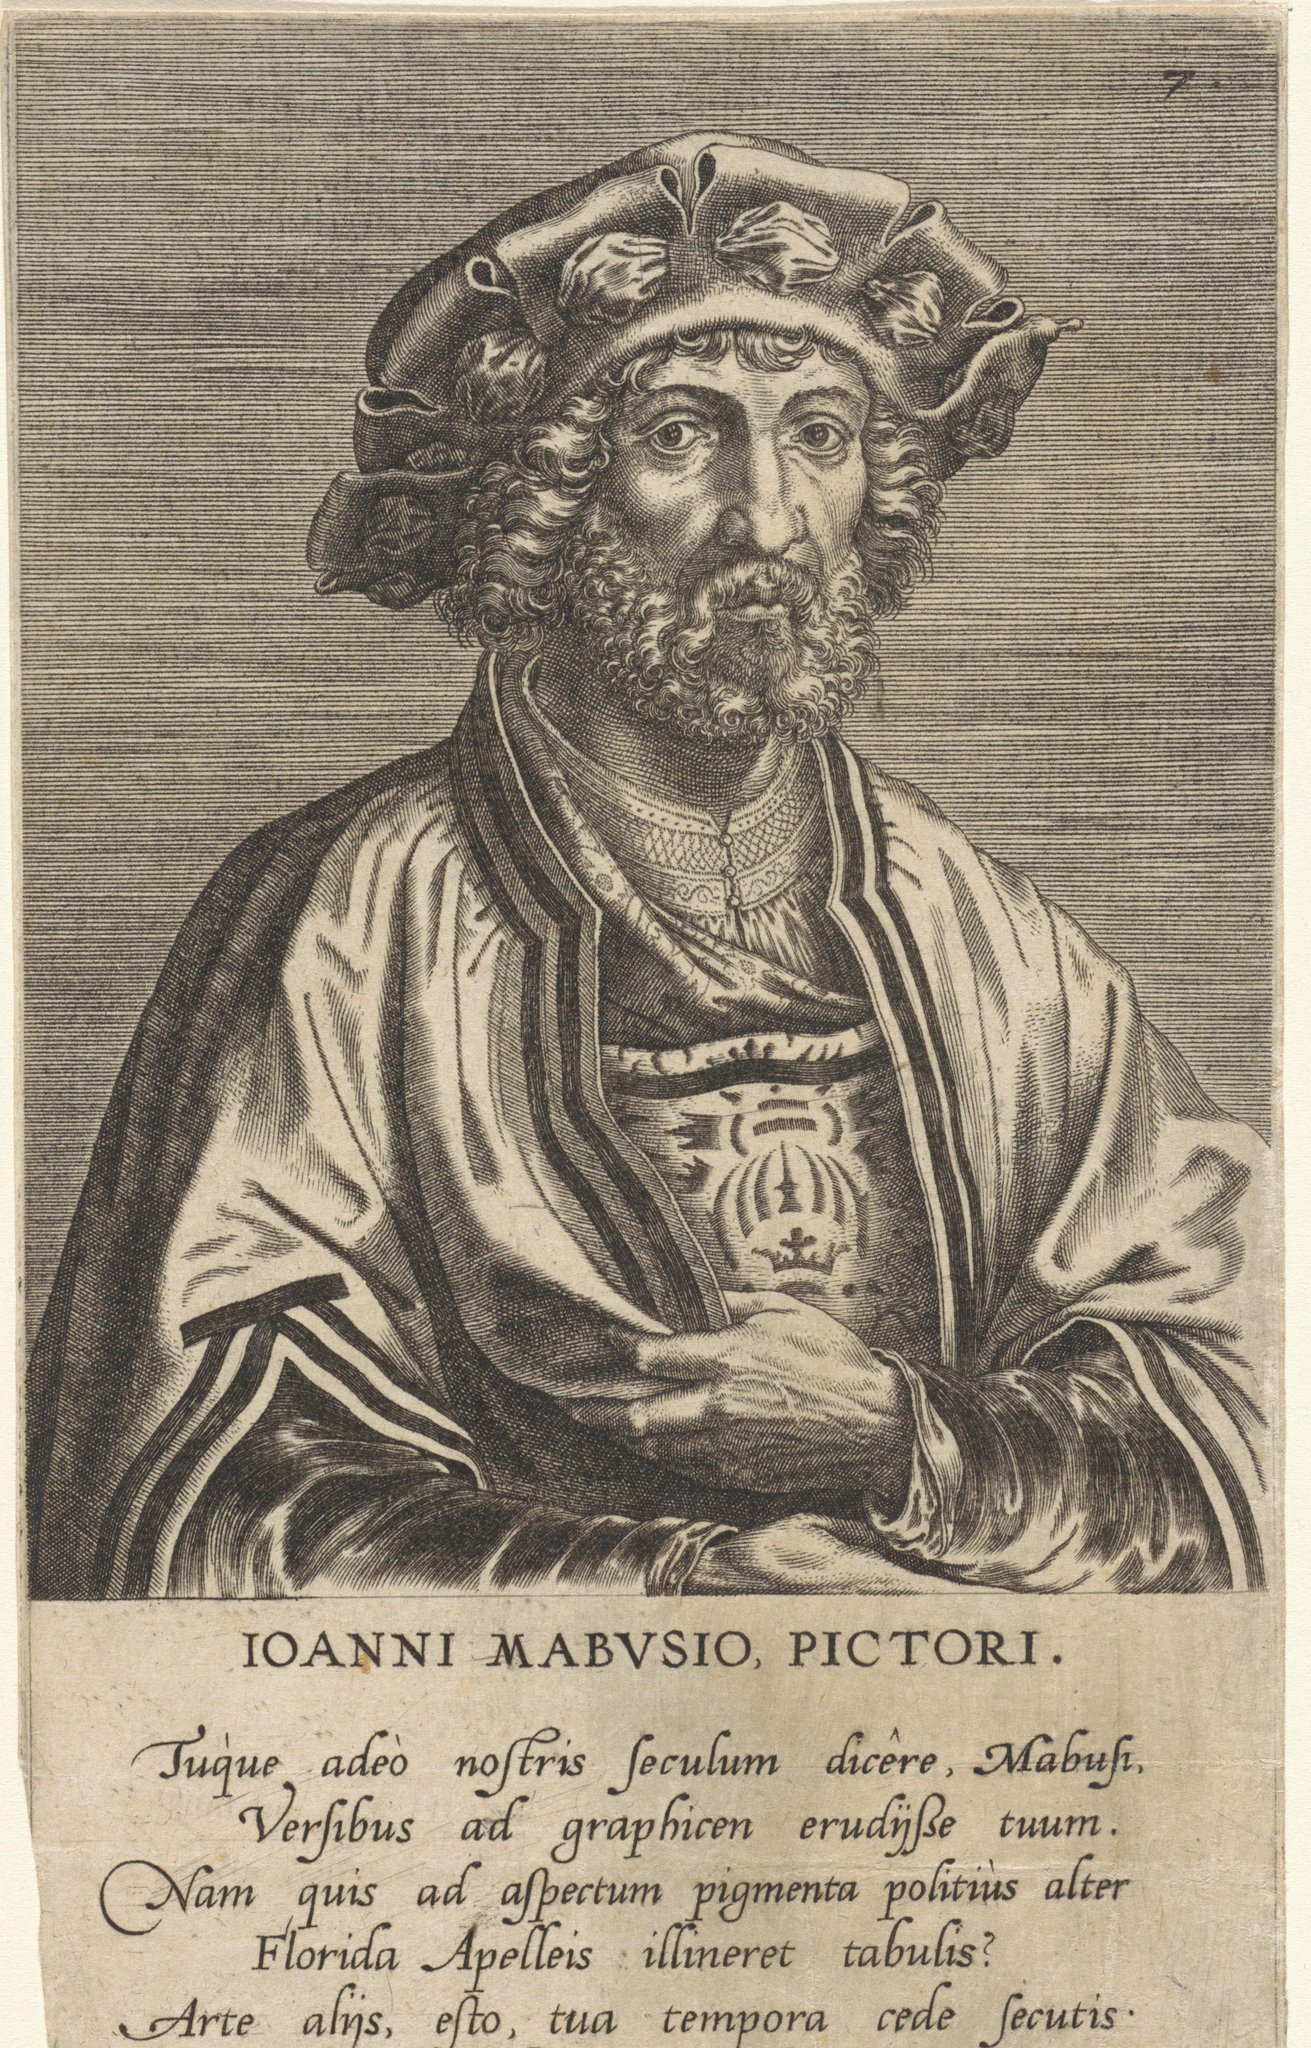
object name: print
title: Portretten van schilders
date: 1572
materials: paper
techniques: engraving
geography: antwerp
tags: antwerp, painter, print maker, draughtsman, jan gossart, portrait, self-portrait of painter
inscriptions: collector's mark: Lugt 2228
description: In de marge een zesregelig onderschrift in het Latijn.